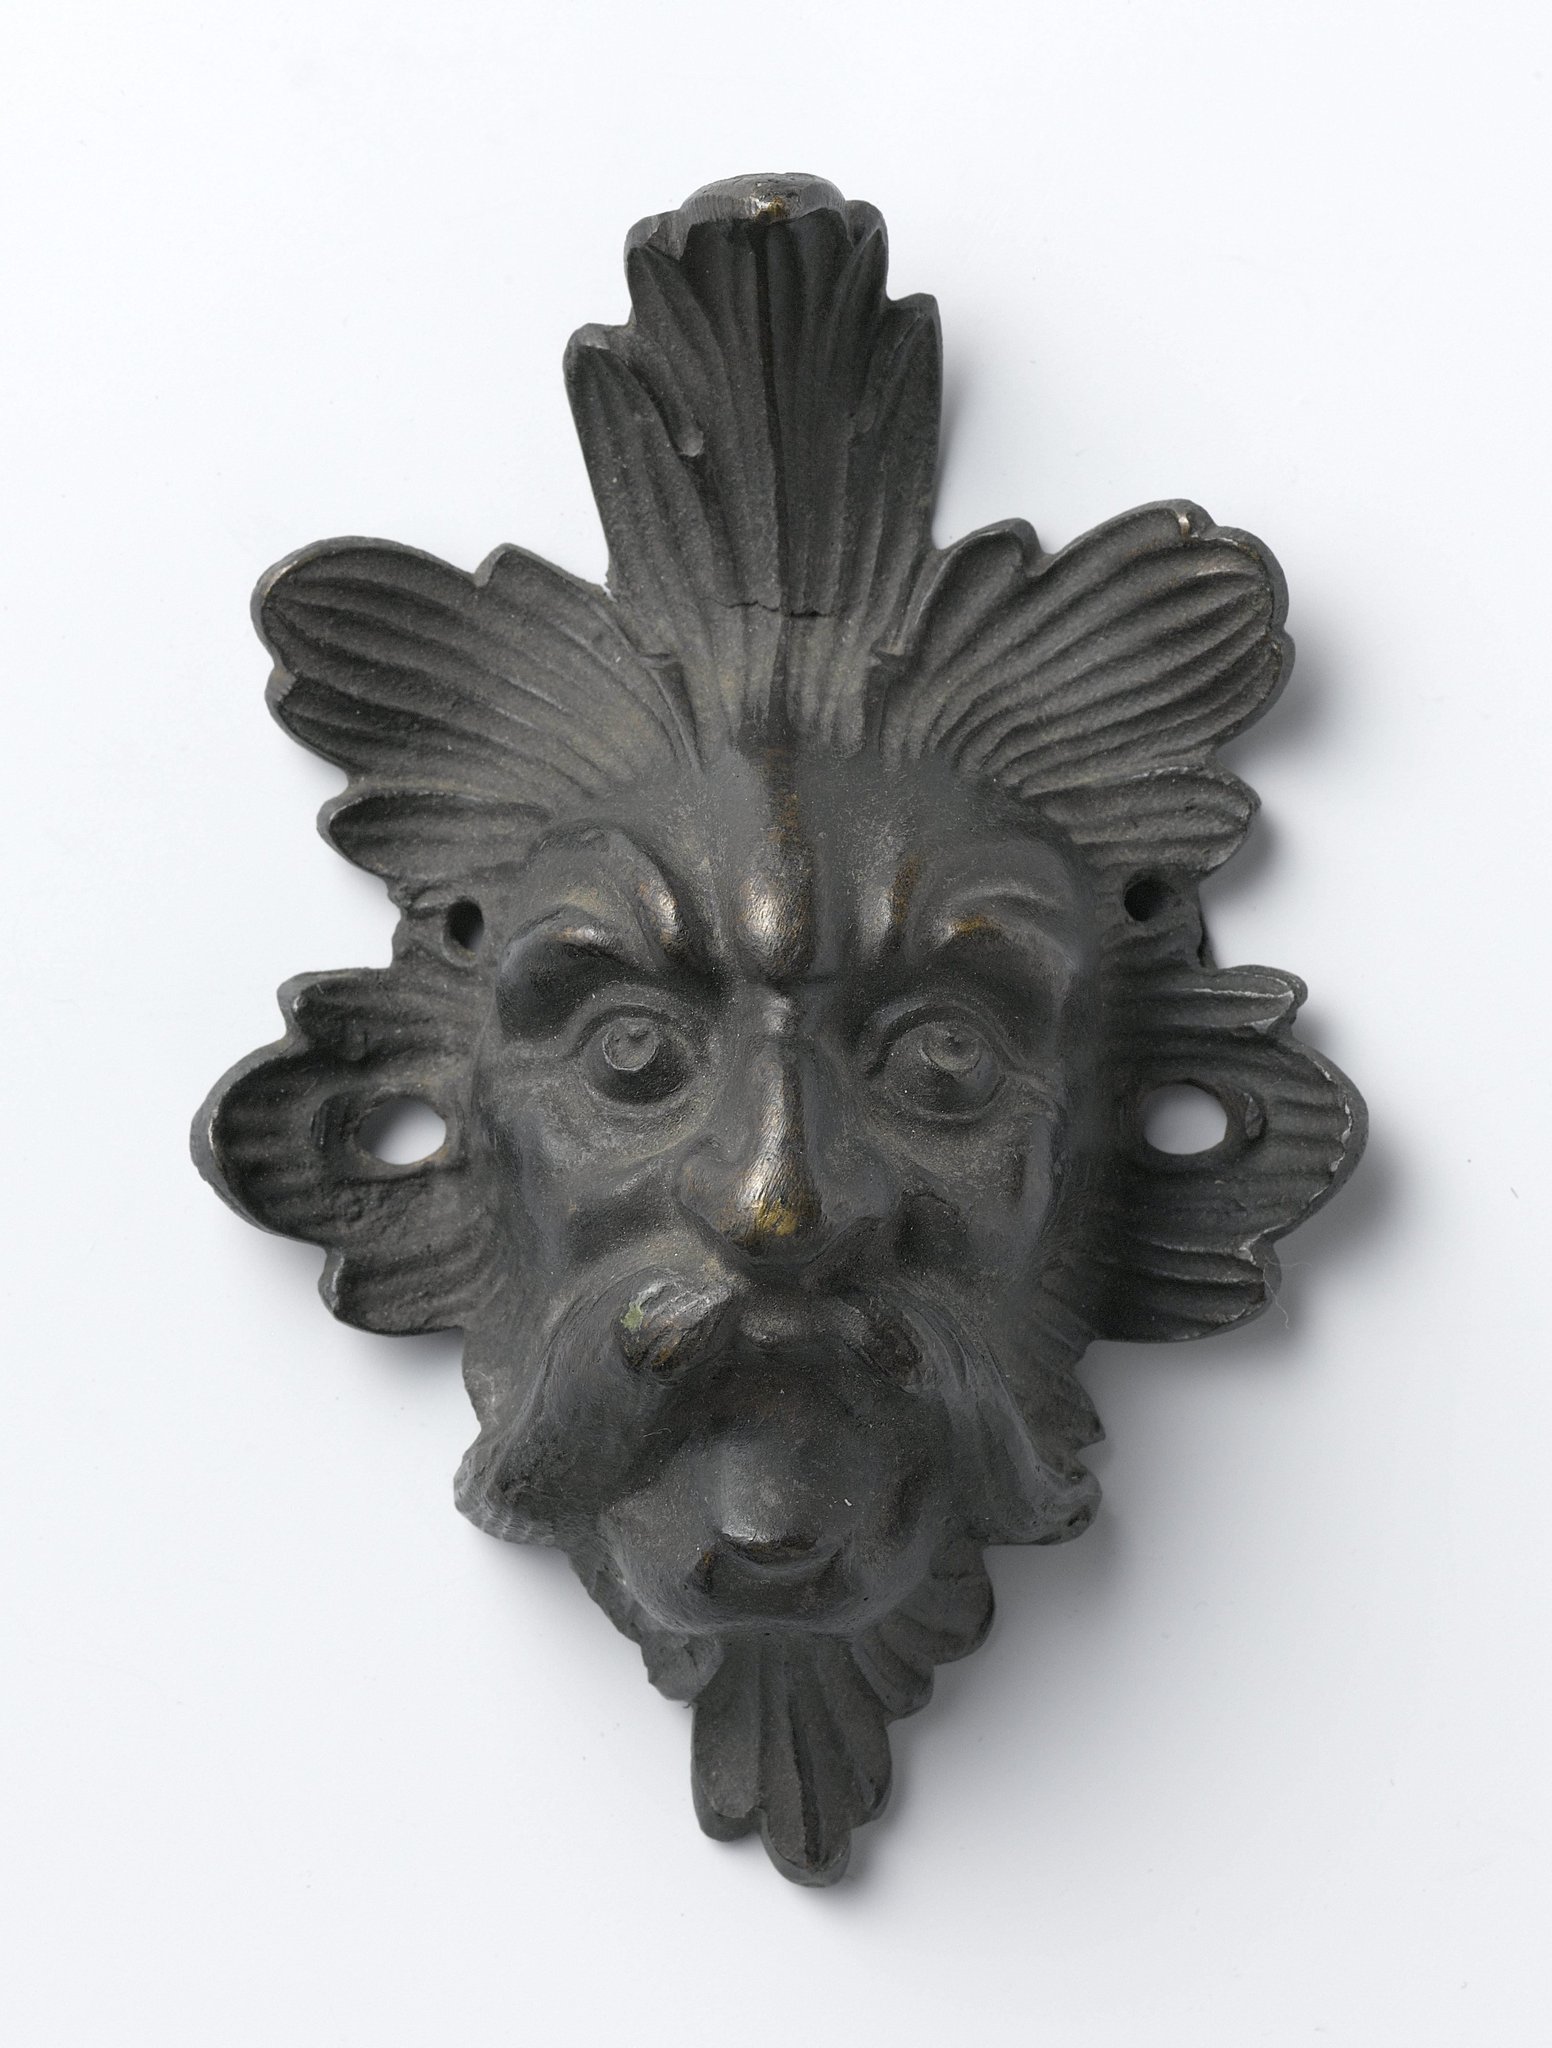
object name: sculpture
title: Mascaron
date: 1600-1699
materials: bronze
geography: italy